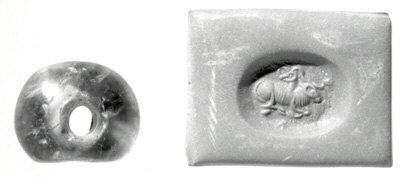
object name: stamp seal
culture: sasanian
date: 401-600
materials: quartz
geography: iran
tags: bulls